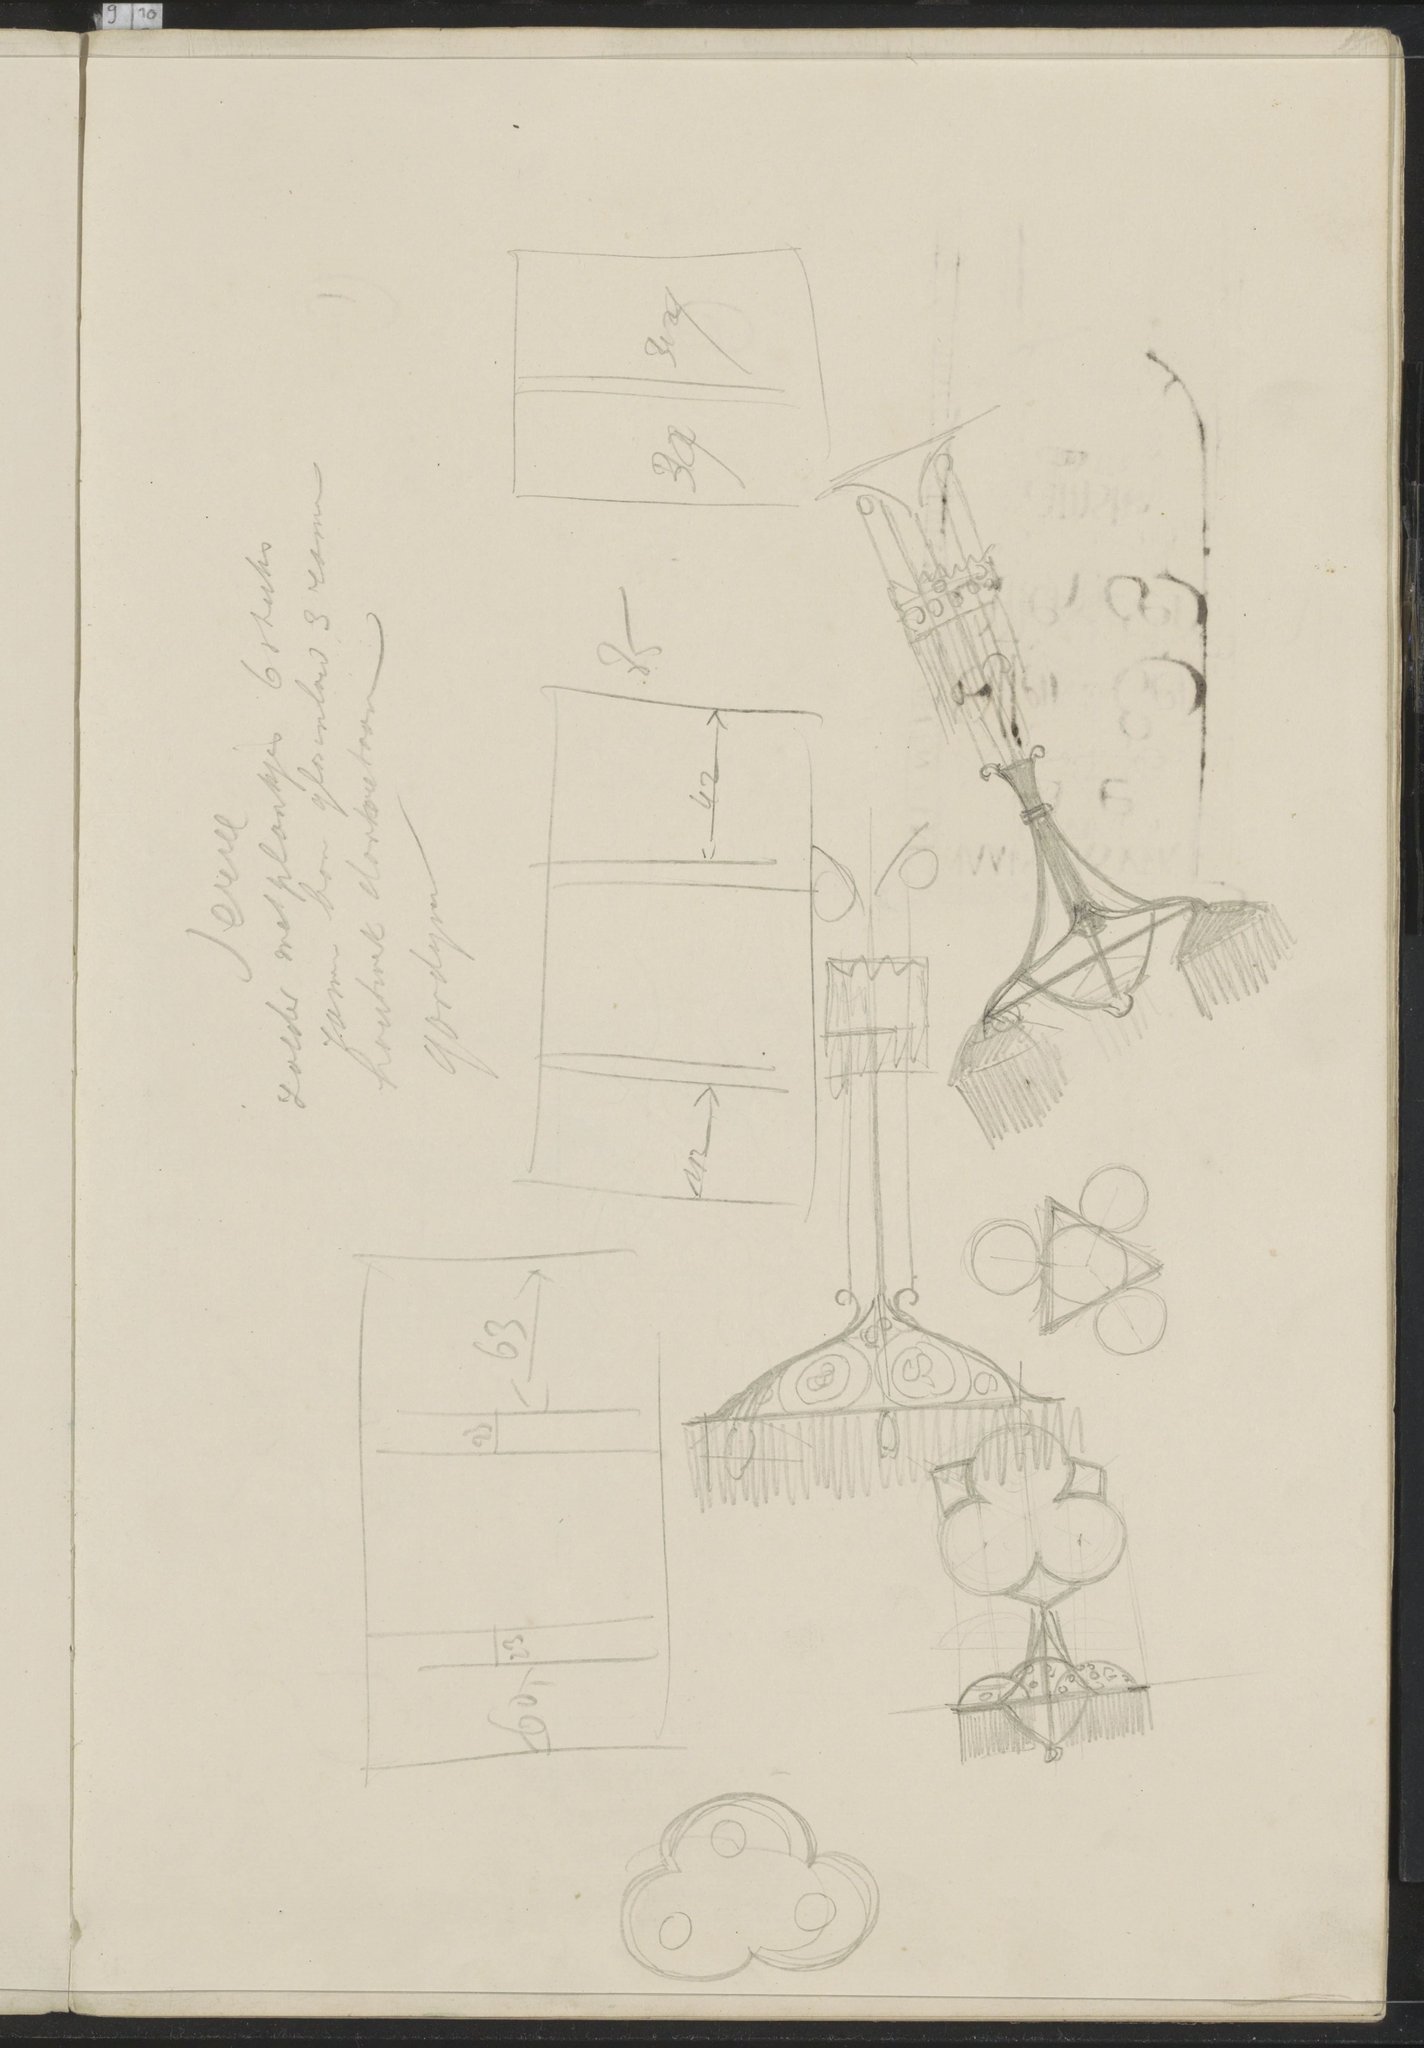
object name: sketchbook leaf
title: Hanglampen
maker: carel adolph lion cachet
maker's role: draughtsman, print maker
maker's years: 1864-1945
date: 1903-1904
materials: paper, pencil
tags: lighting; lamps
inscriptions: annotation: ‘serre/ zolder met plankjes 61 stuks/ ramen [....] glas [...] 3 ramen/ houtwerk daarbuiten/ gordijnen’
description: Tevens een ontwerp voor vensters voor een serre. Blad 5 recto uit een schetsboek met 17 bladen.